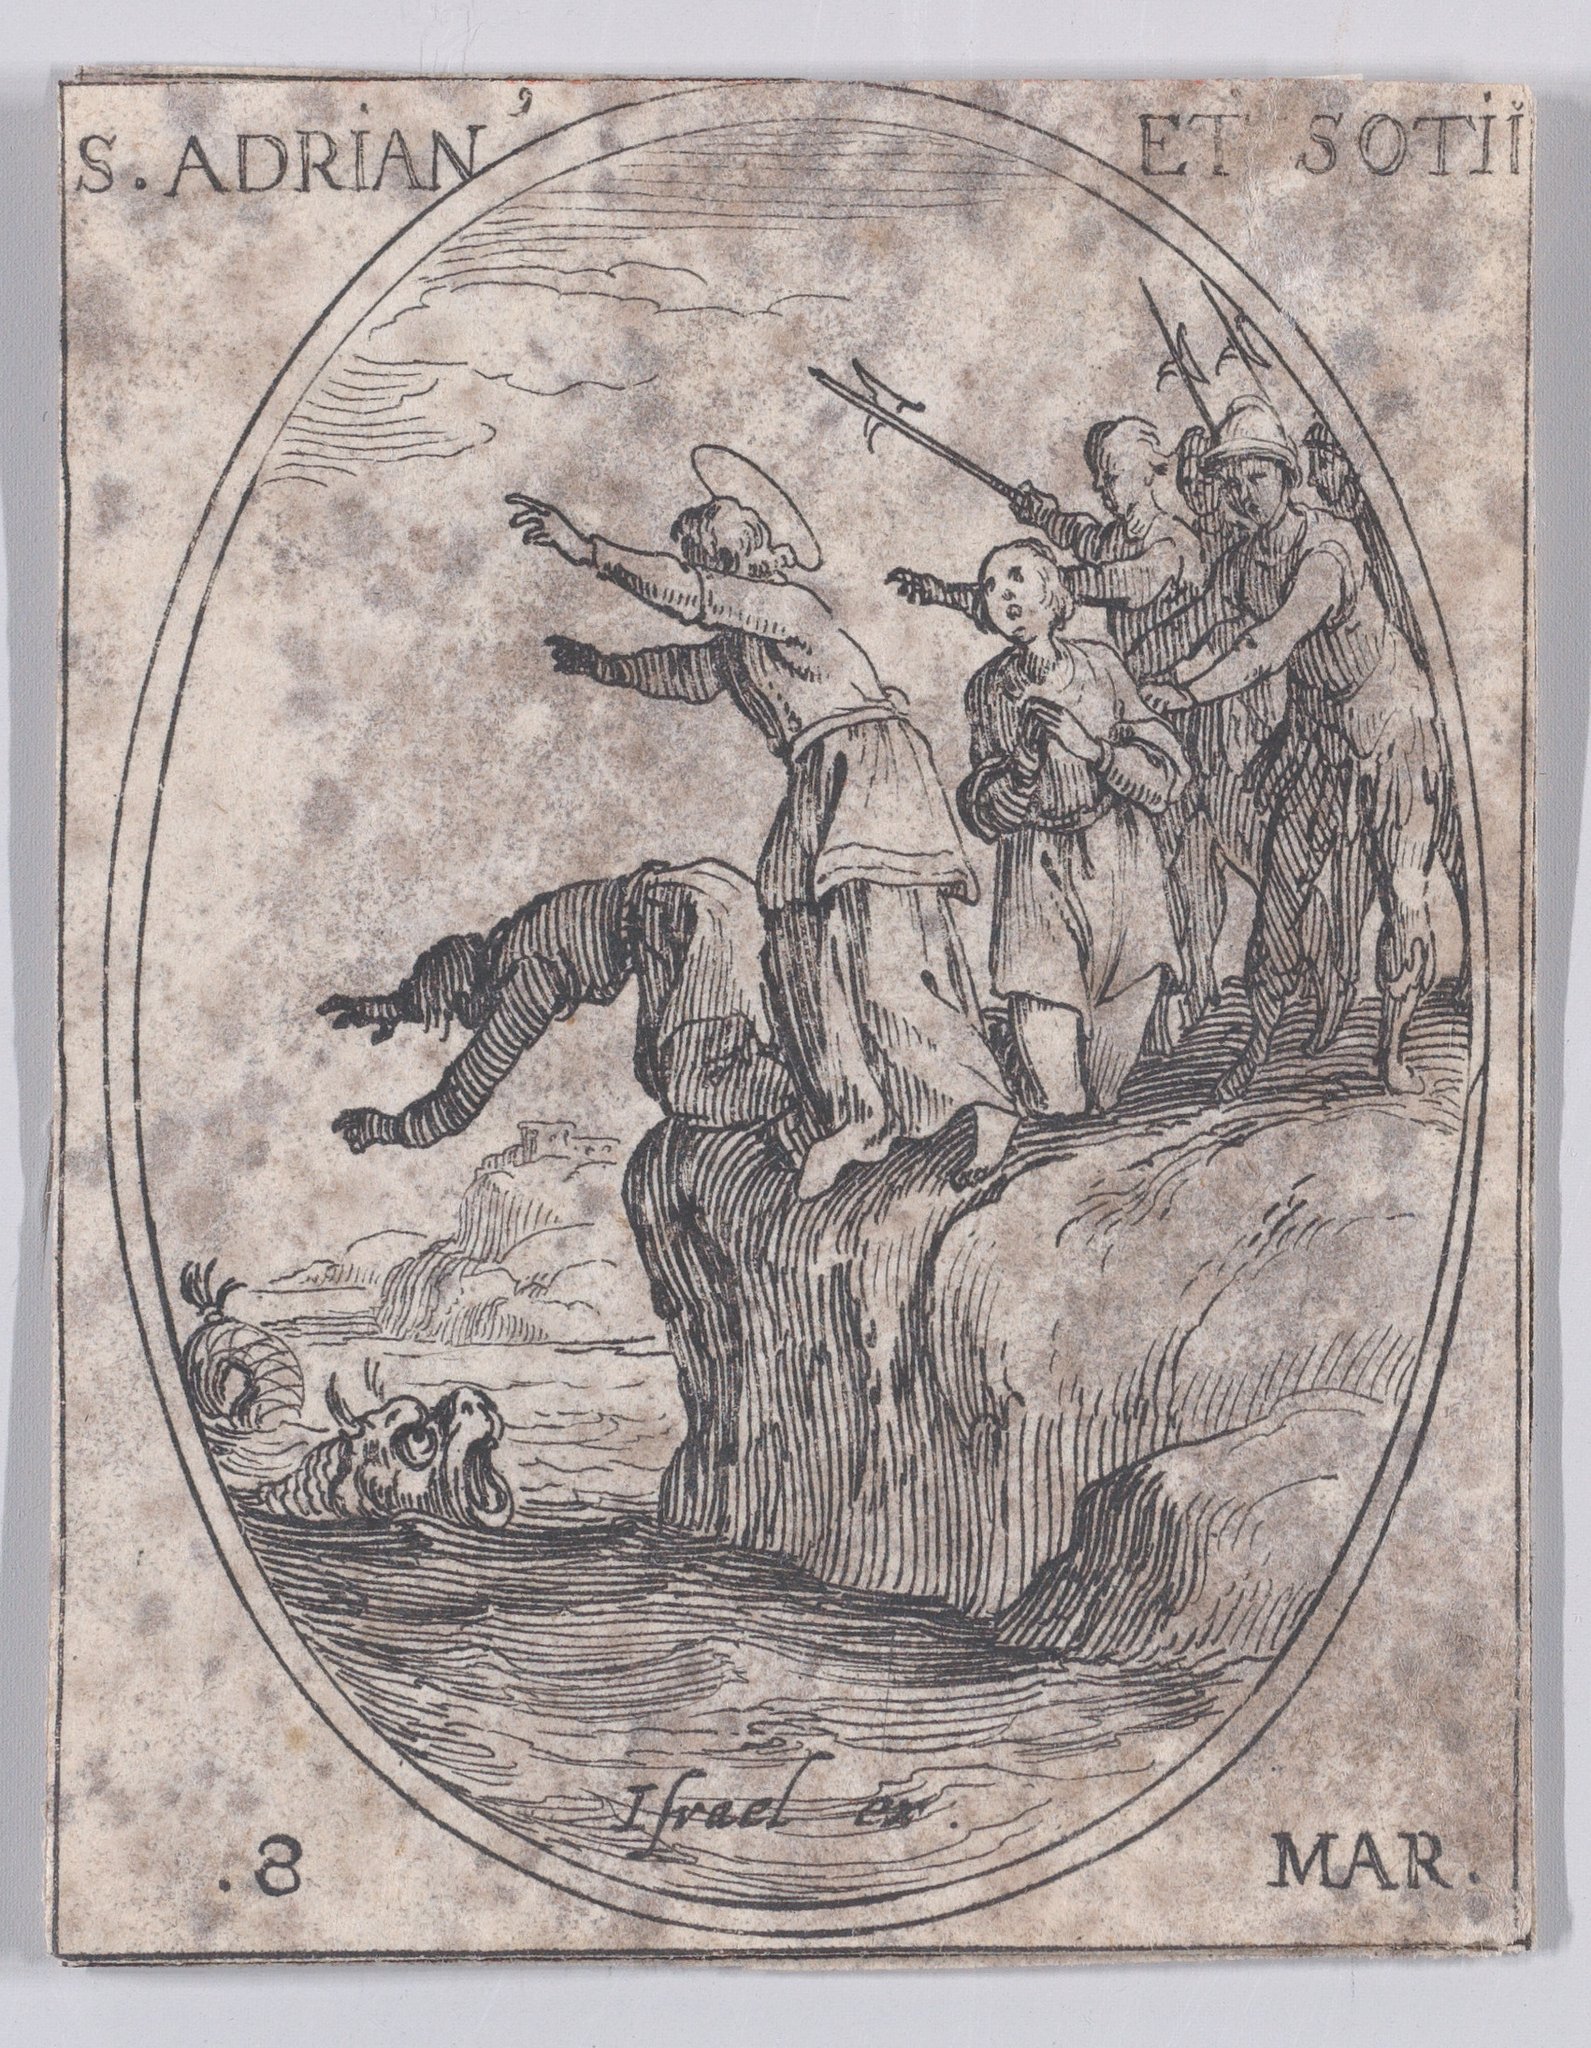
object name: print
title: S. Adrien et Ses Compagnons (St. Adrian and His Companions), March 8th, from "Les Images De Tous Les Saincts et Saintes de L'Année" (Images of All of the Saints and Religious Events of the Year)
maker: jacques callot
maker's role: artist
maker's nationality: french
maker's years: 1592-1635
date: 1636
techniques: etching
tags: men,saints